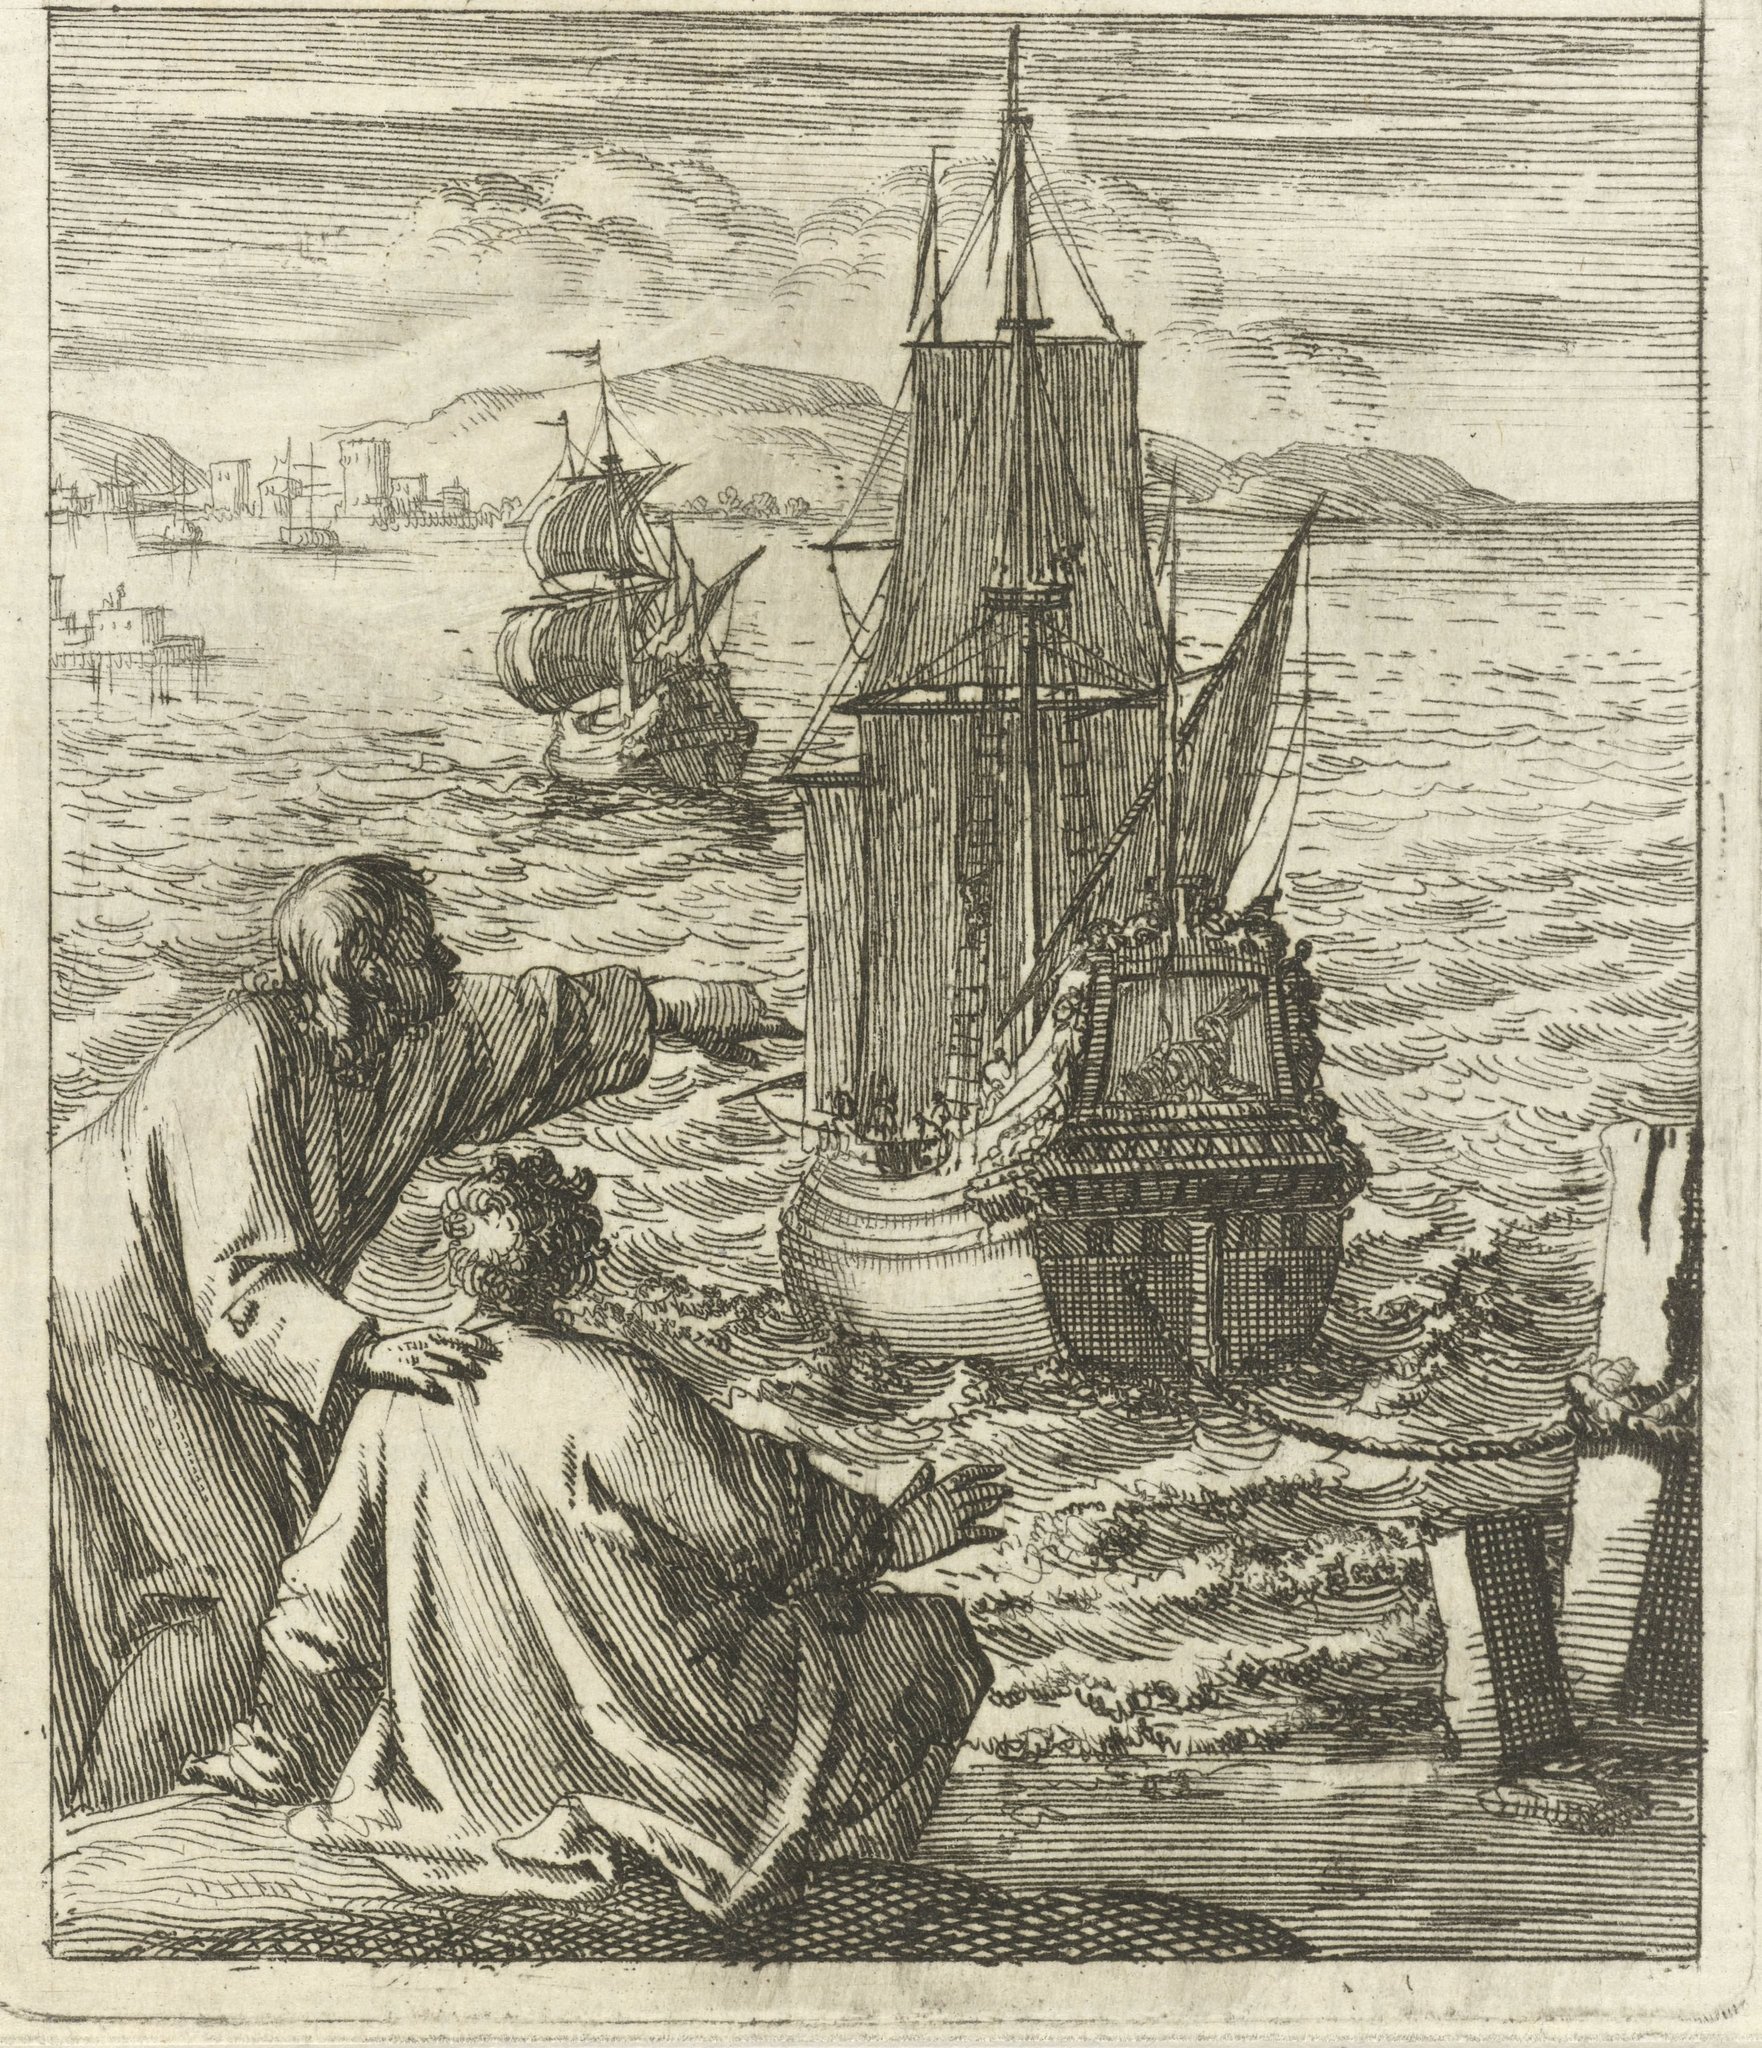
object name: print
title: Ontbind, en spoed, u van de Wal Zo wind, en vloed, u baten zal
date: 1689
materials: paper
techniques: etching, letterpress printing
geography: amsterdam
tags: sailing-ship, sailing-boat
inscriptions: collector's mark: Lugt 2228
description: Illustratie uit: Huygen, Pieter. De beginselen van Gods koninkryk in den mensch uitgedrukt in zinnebeelden. Amsterdam: wed. Arentsz. Pieter (II), 1689, p. 92.